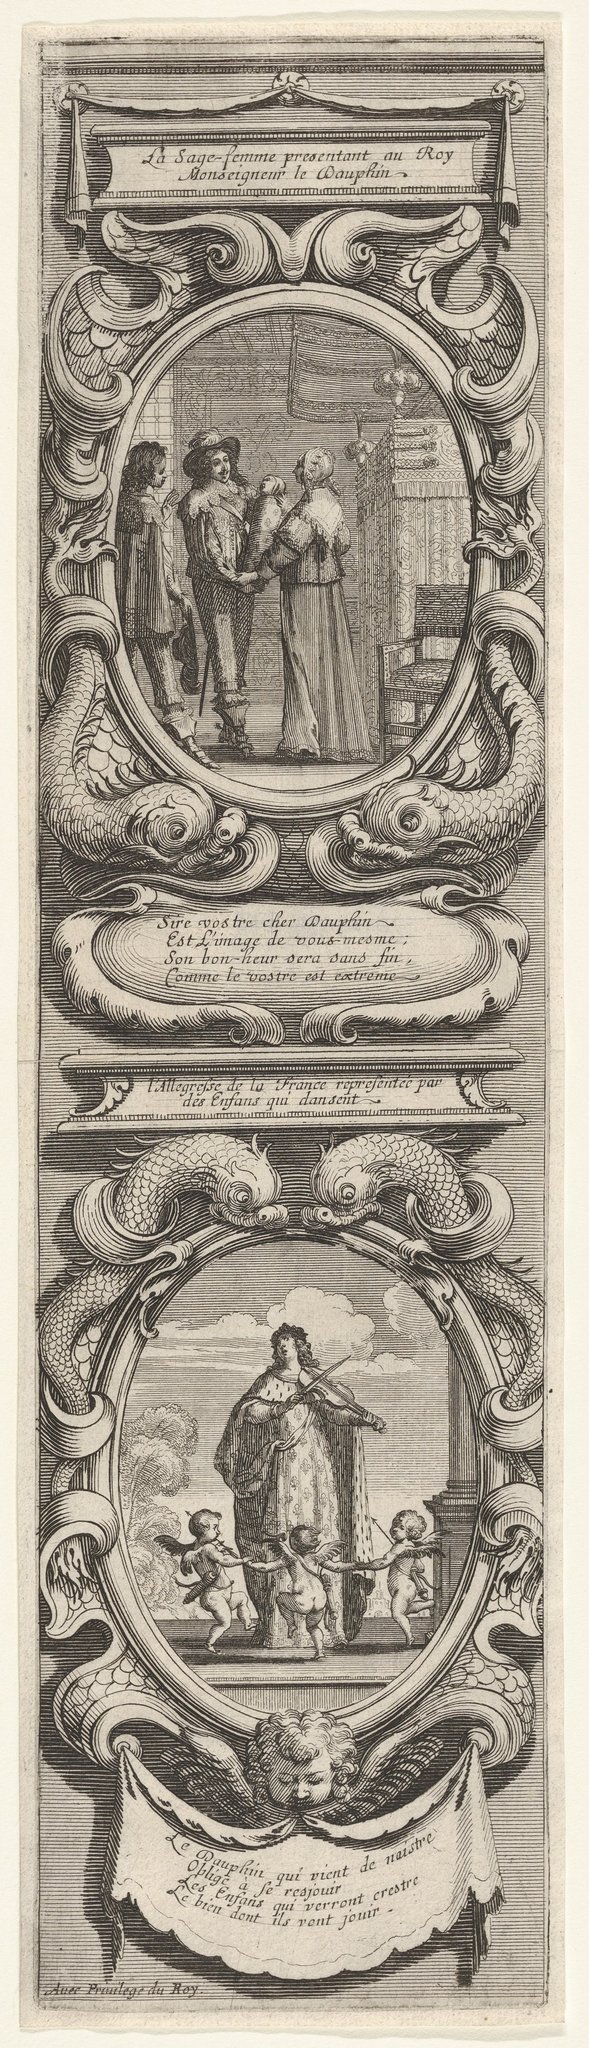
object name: print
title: Allegories in Honor of the Birth of the Dauphin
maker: abraham bosse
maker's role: artist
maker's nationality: french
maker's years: 1602-1676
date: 1638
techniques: etching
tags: infants,men,women,cupid,birth